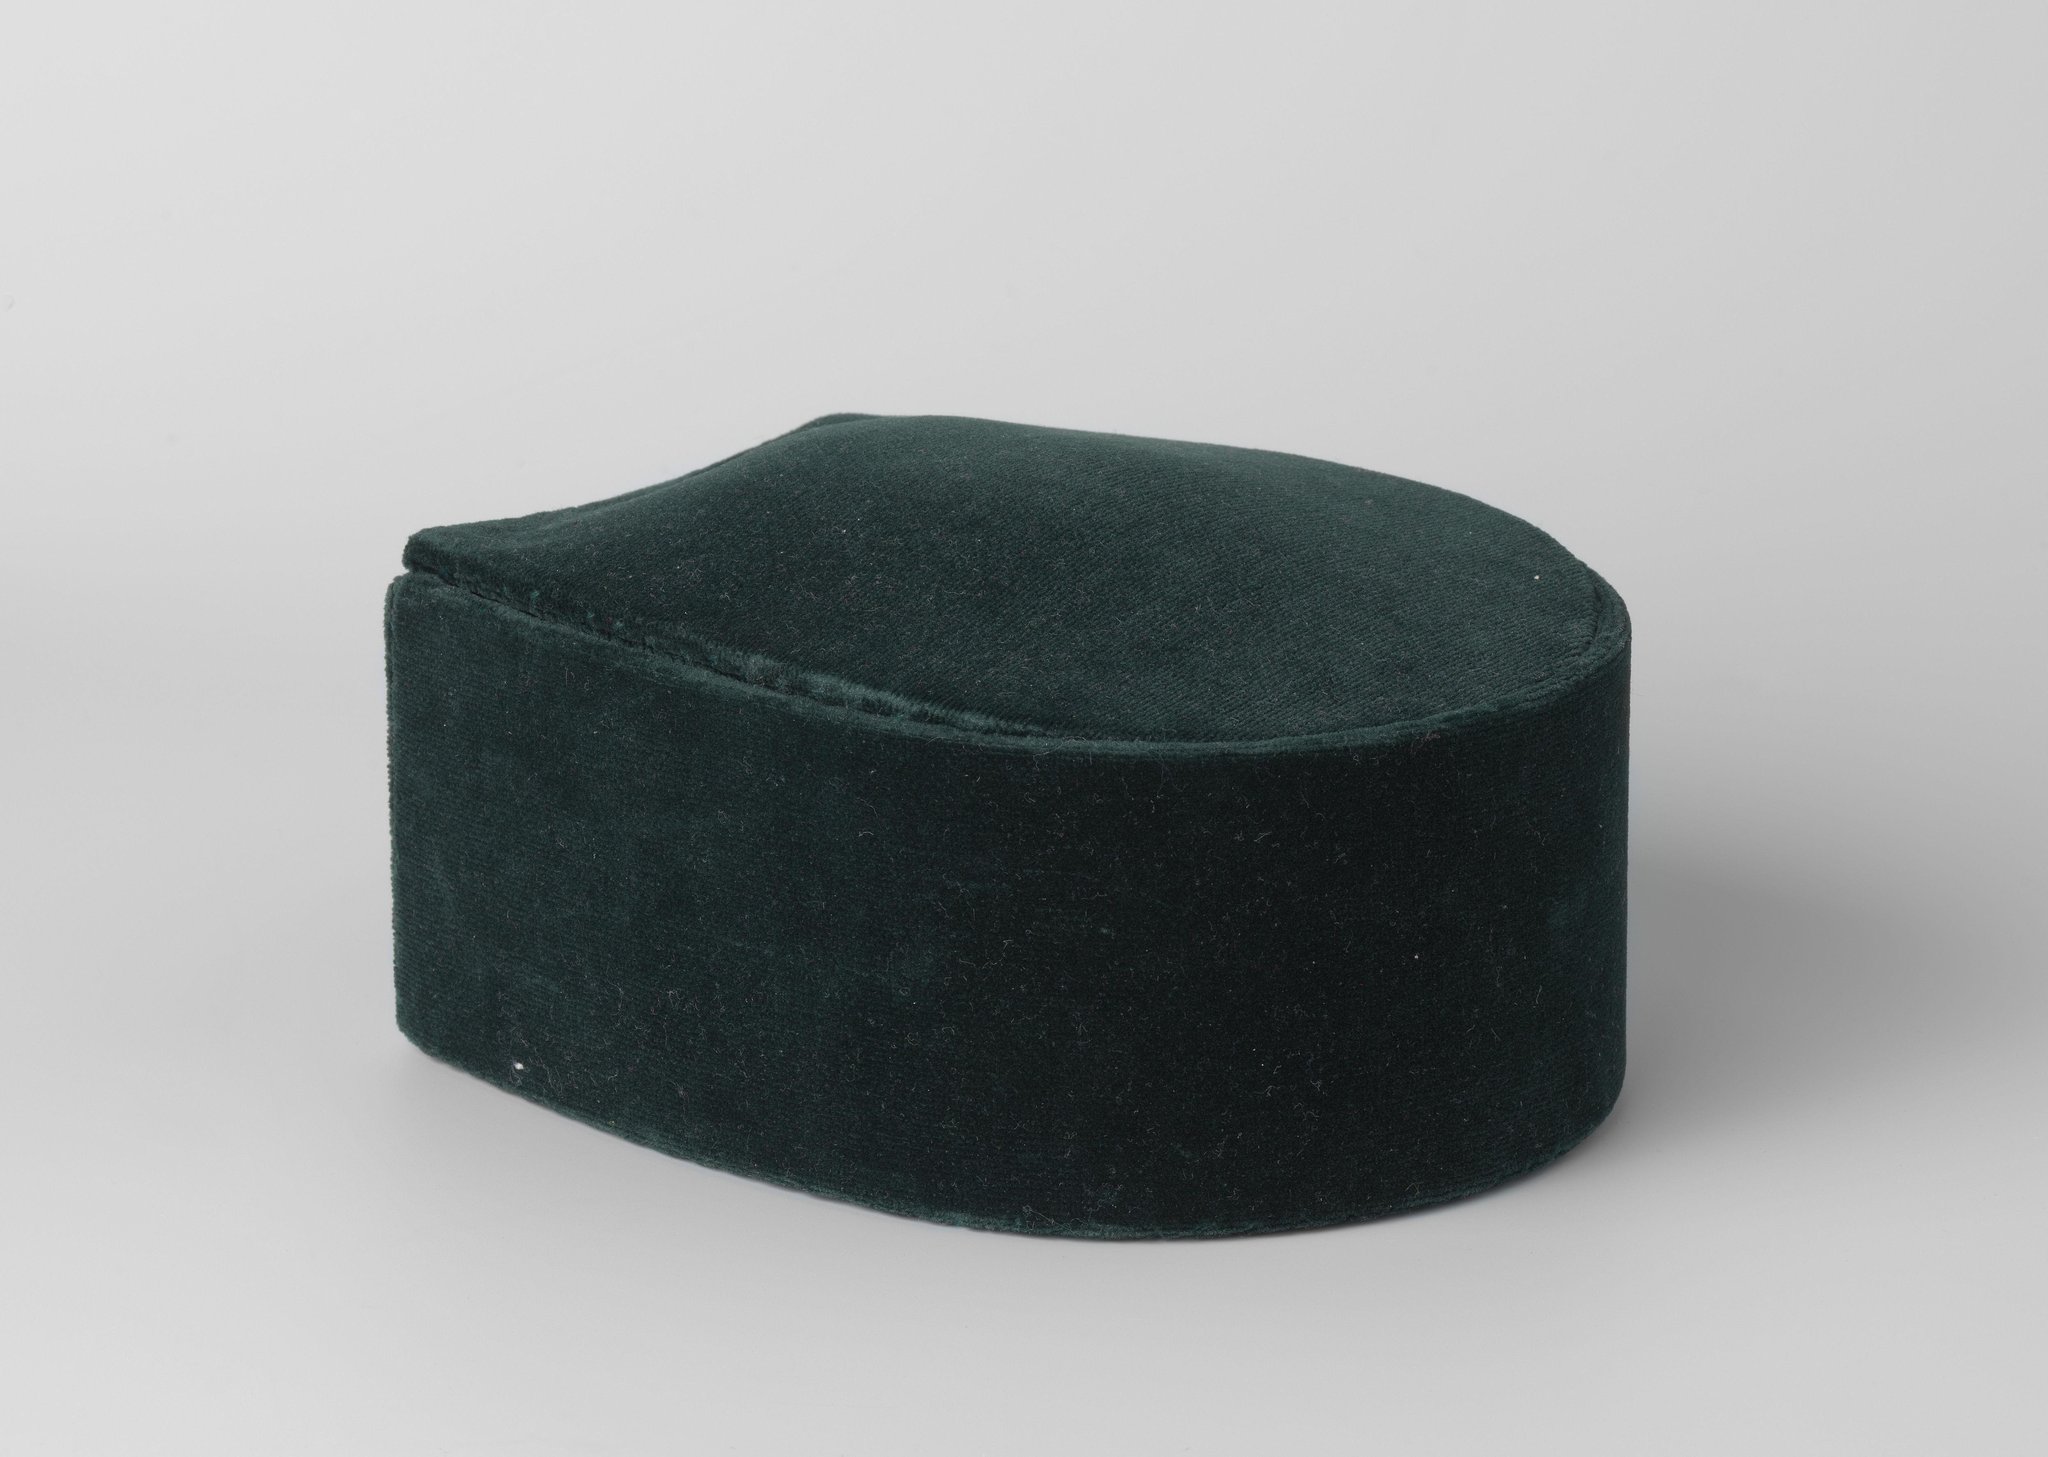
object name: case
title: Foedraal van groen velours met scharnierend deksel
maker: christian astuguevieille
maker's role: designer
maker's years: 1946-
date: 2000-2010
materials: cardboard, metal, velvet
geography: paris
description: In het foedraal is een sticker van Pierre Bergé & Ass. aangetroffen met daarop 19 juin / juni 2012 / 184 (lotnummer).